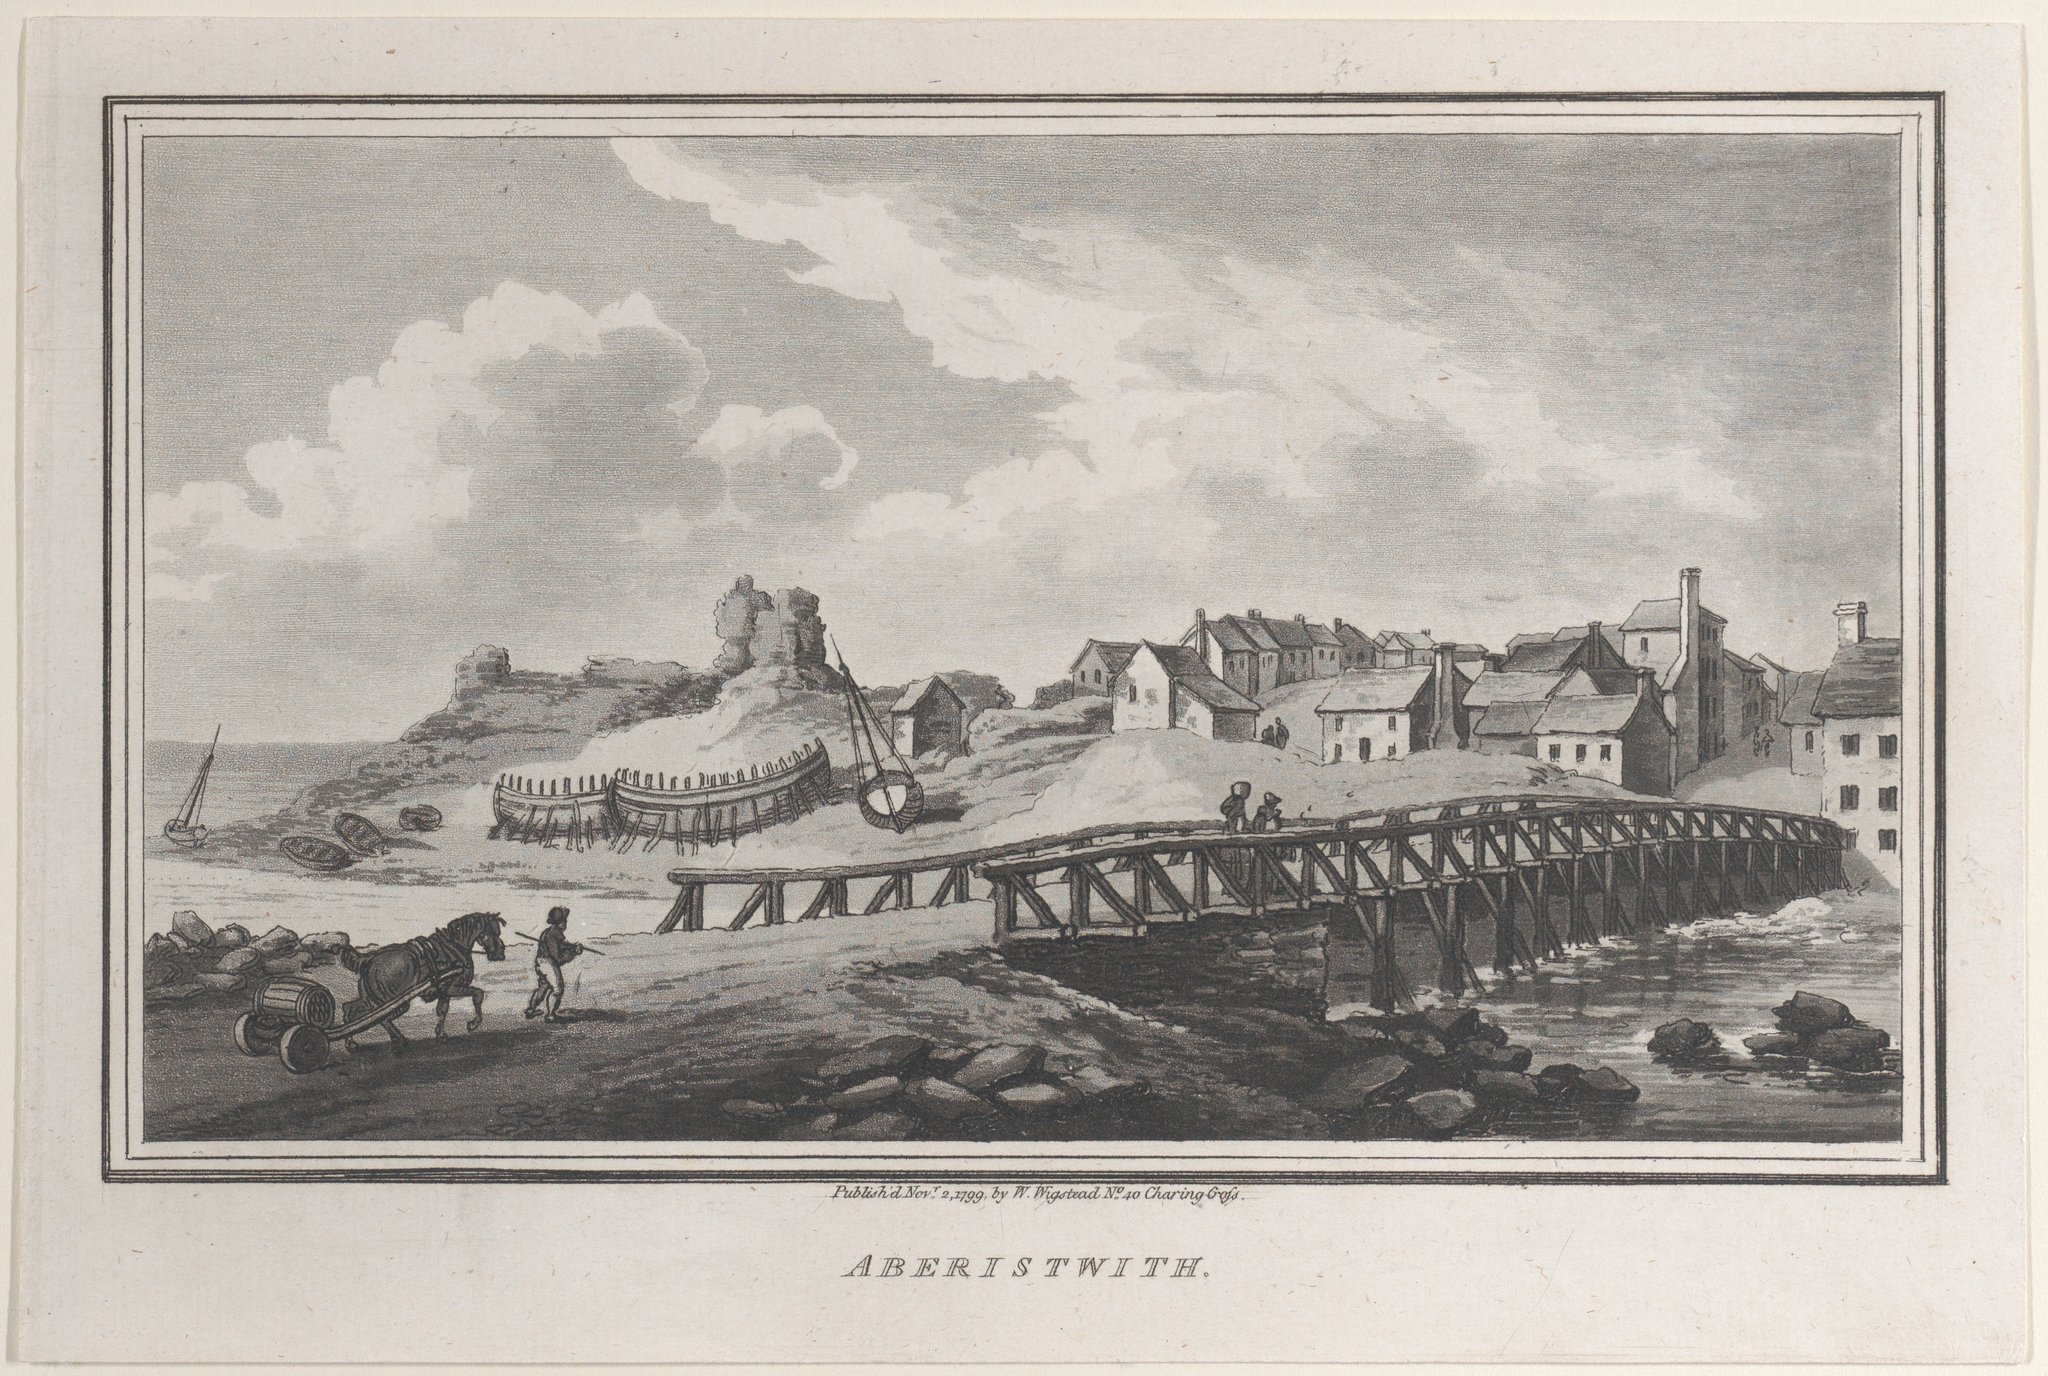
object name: print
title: Aberistwith, from "Remarks on a Tour to North and South Wales, in the year 1797"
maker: john hill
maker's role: artist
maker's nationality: british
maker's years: 1714-1775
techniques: aquatint, etching